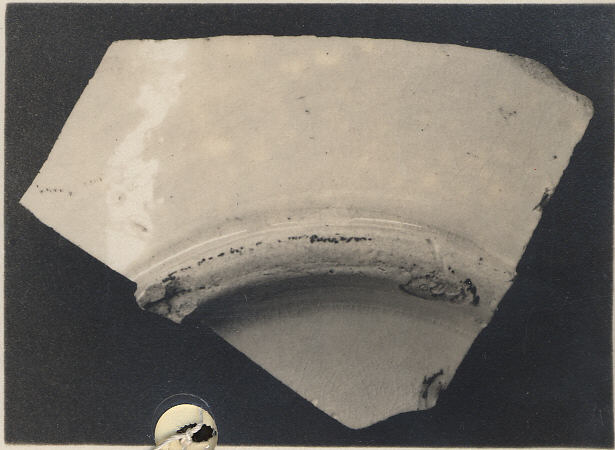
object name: fragment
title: Fragment of a Bowl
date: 801-900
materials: glaze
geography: china